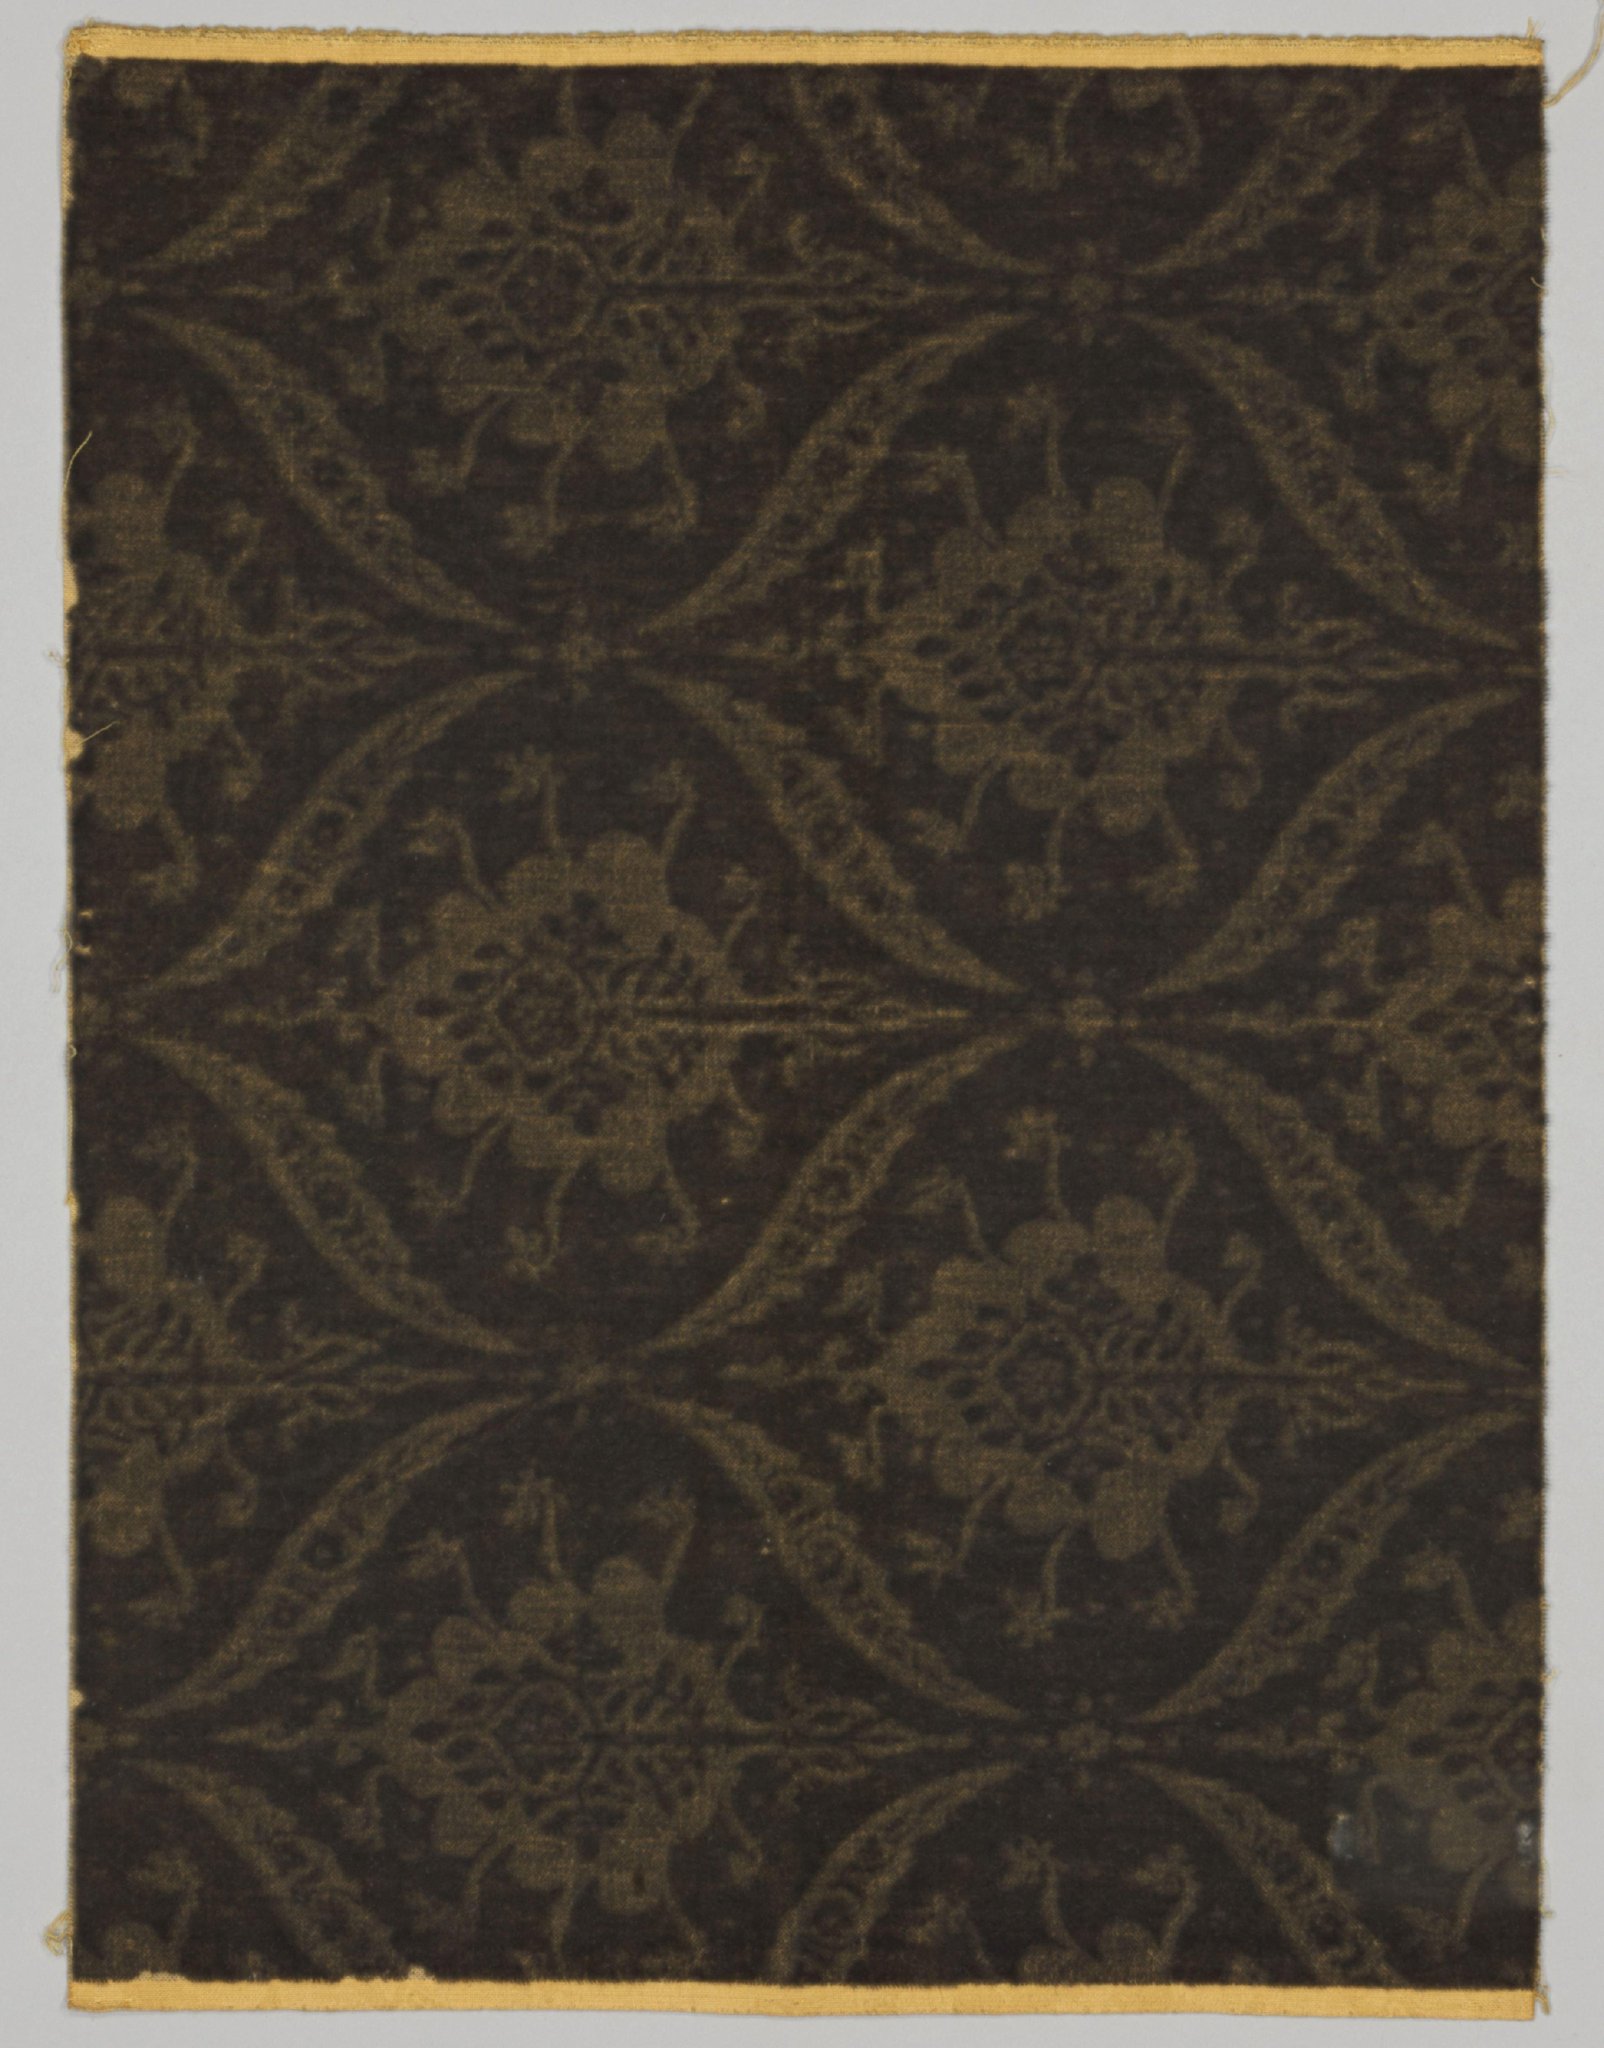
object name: bekledingsstof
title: Ingeschoren trijp, dessin "Duinroos", in zachtpaars op geel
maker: theo nieuwenhuis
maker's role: designer, draughtsman, print maker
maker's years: 1866-1951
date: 1920-1930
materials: cotton, textile, hair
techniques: relief velvet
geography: netherlands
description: Bekledings- of bespanningsstof, ingeschoren trijp, met dessin "Duinroos", in zachtpaars op geel.